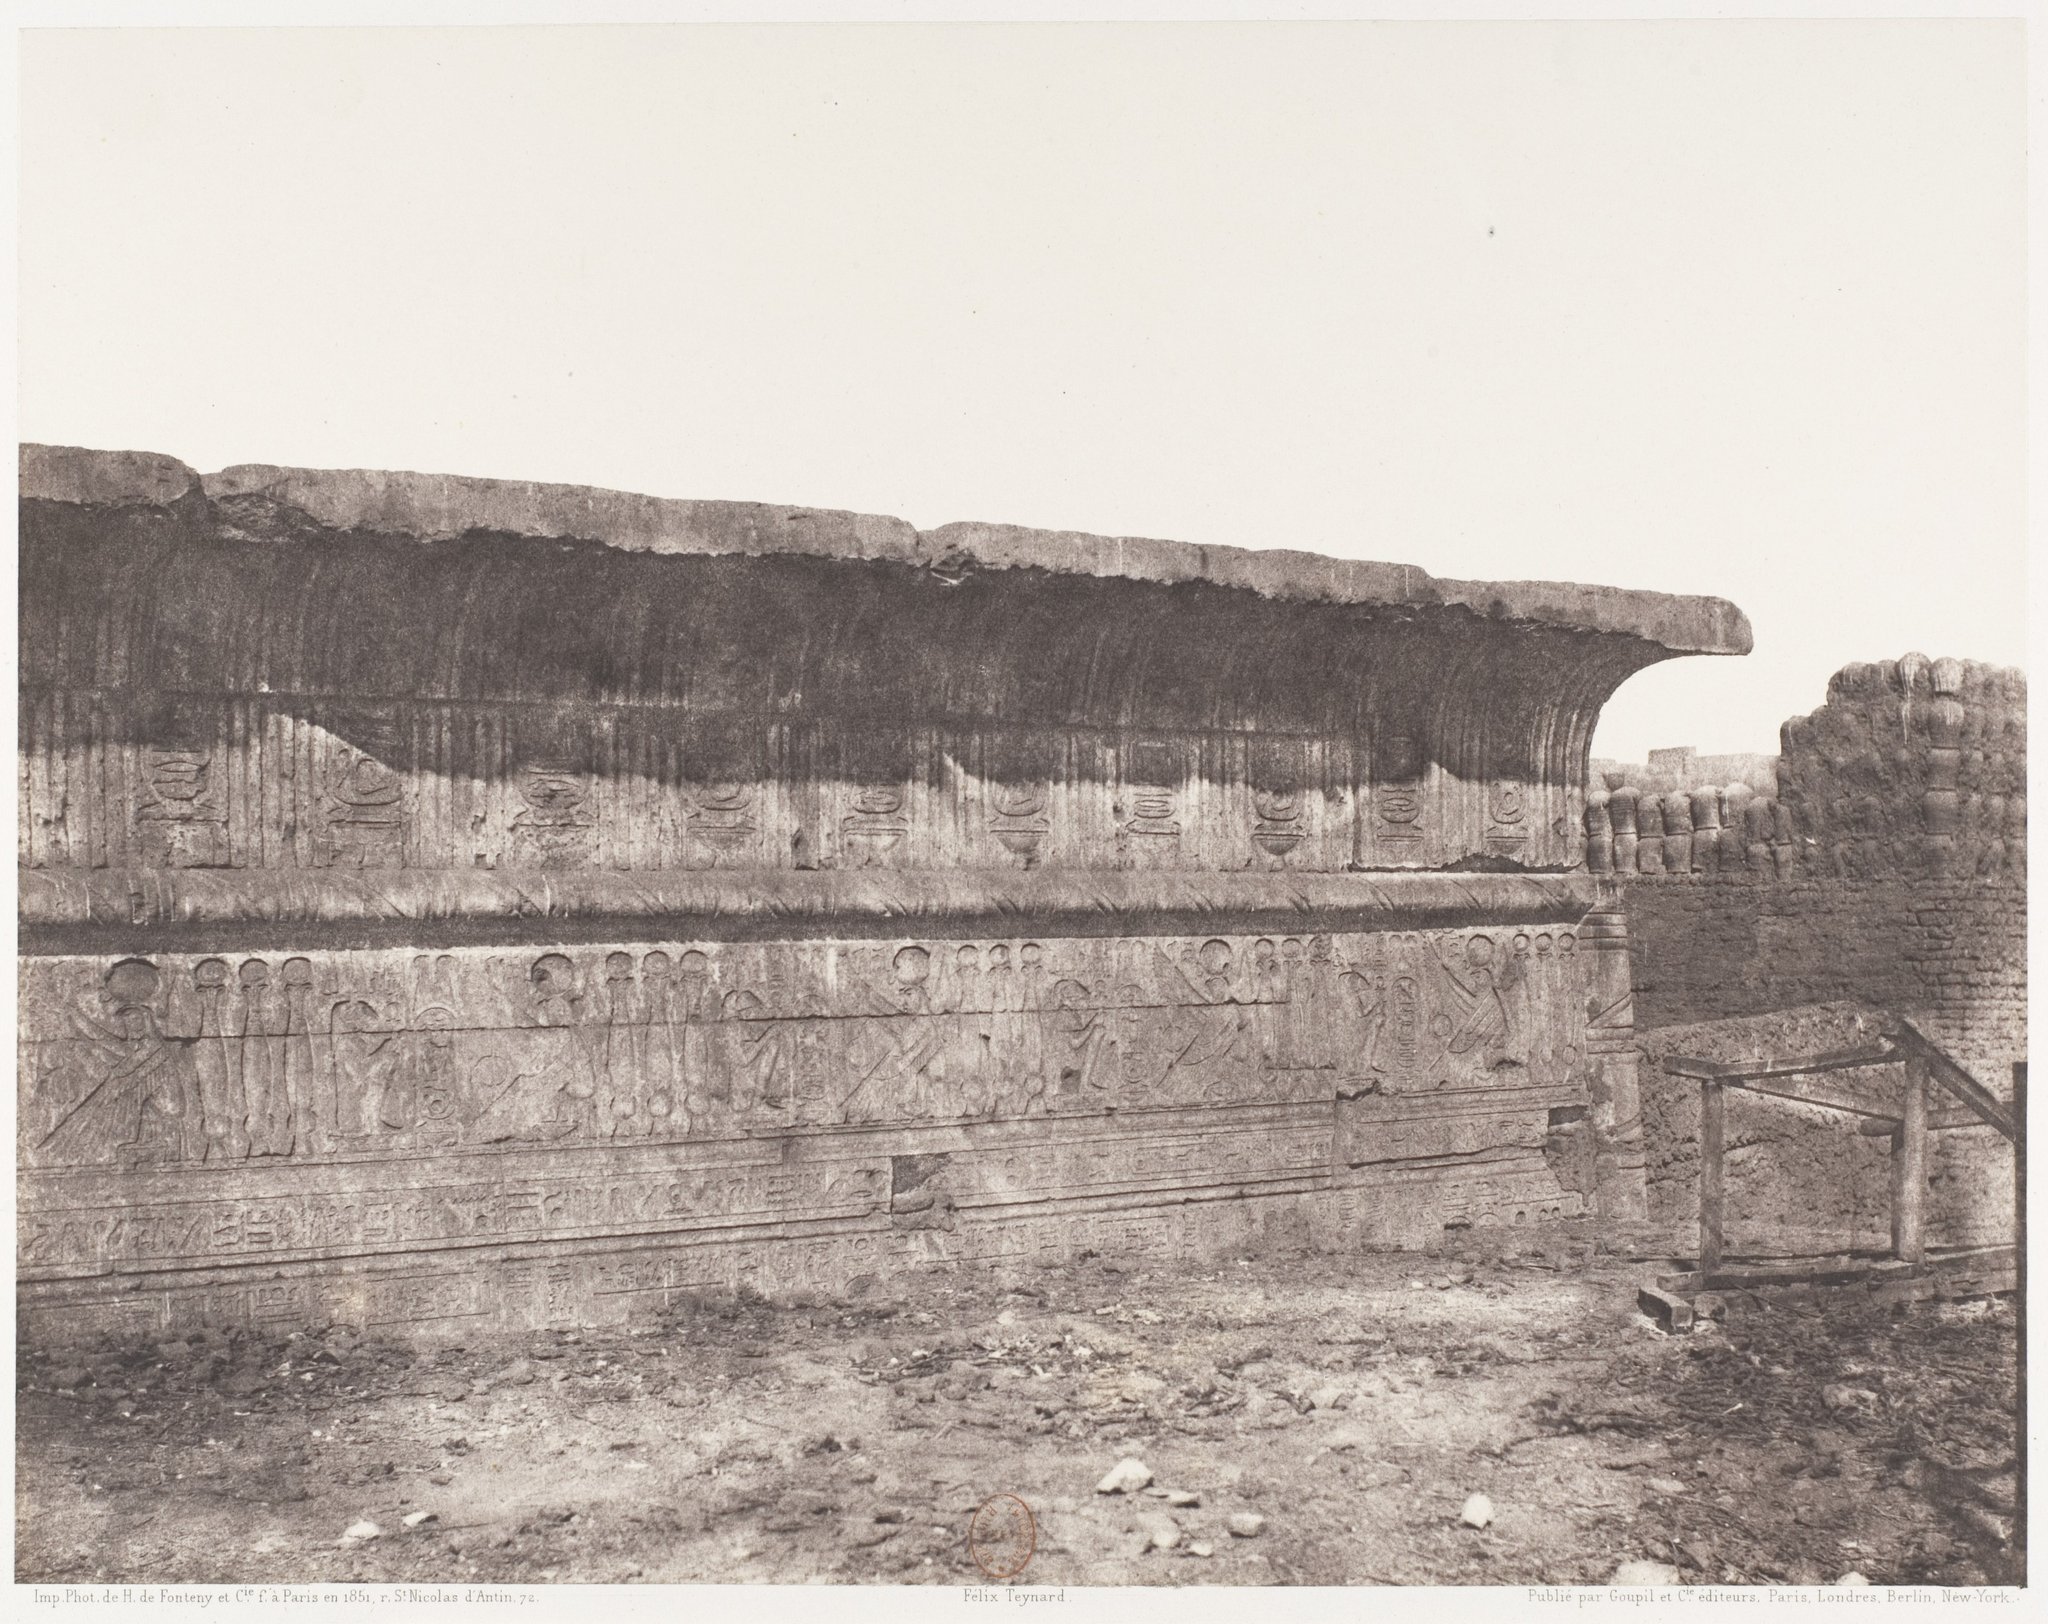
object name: photograph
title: Esneh (Latopolis), Construction Ensablée - Paroi Extérieure - Corniche et Sculptures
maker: félix teynard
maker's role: artist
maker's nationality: french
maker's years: 1817-1892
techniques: paper negative, salted paper print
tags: architecture,ruins